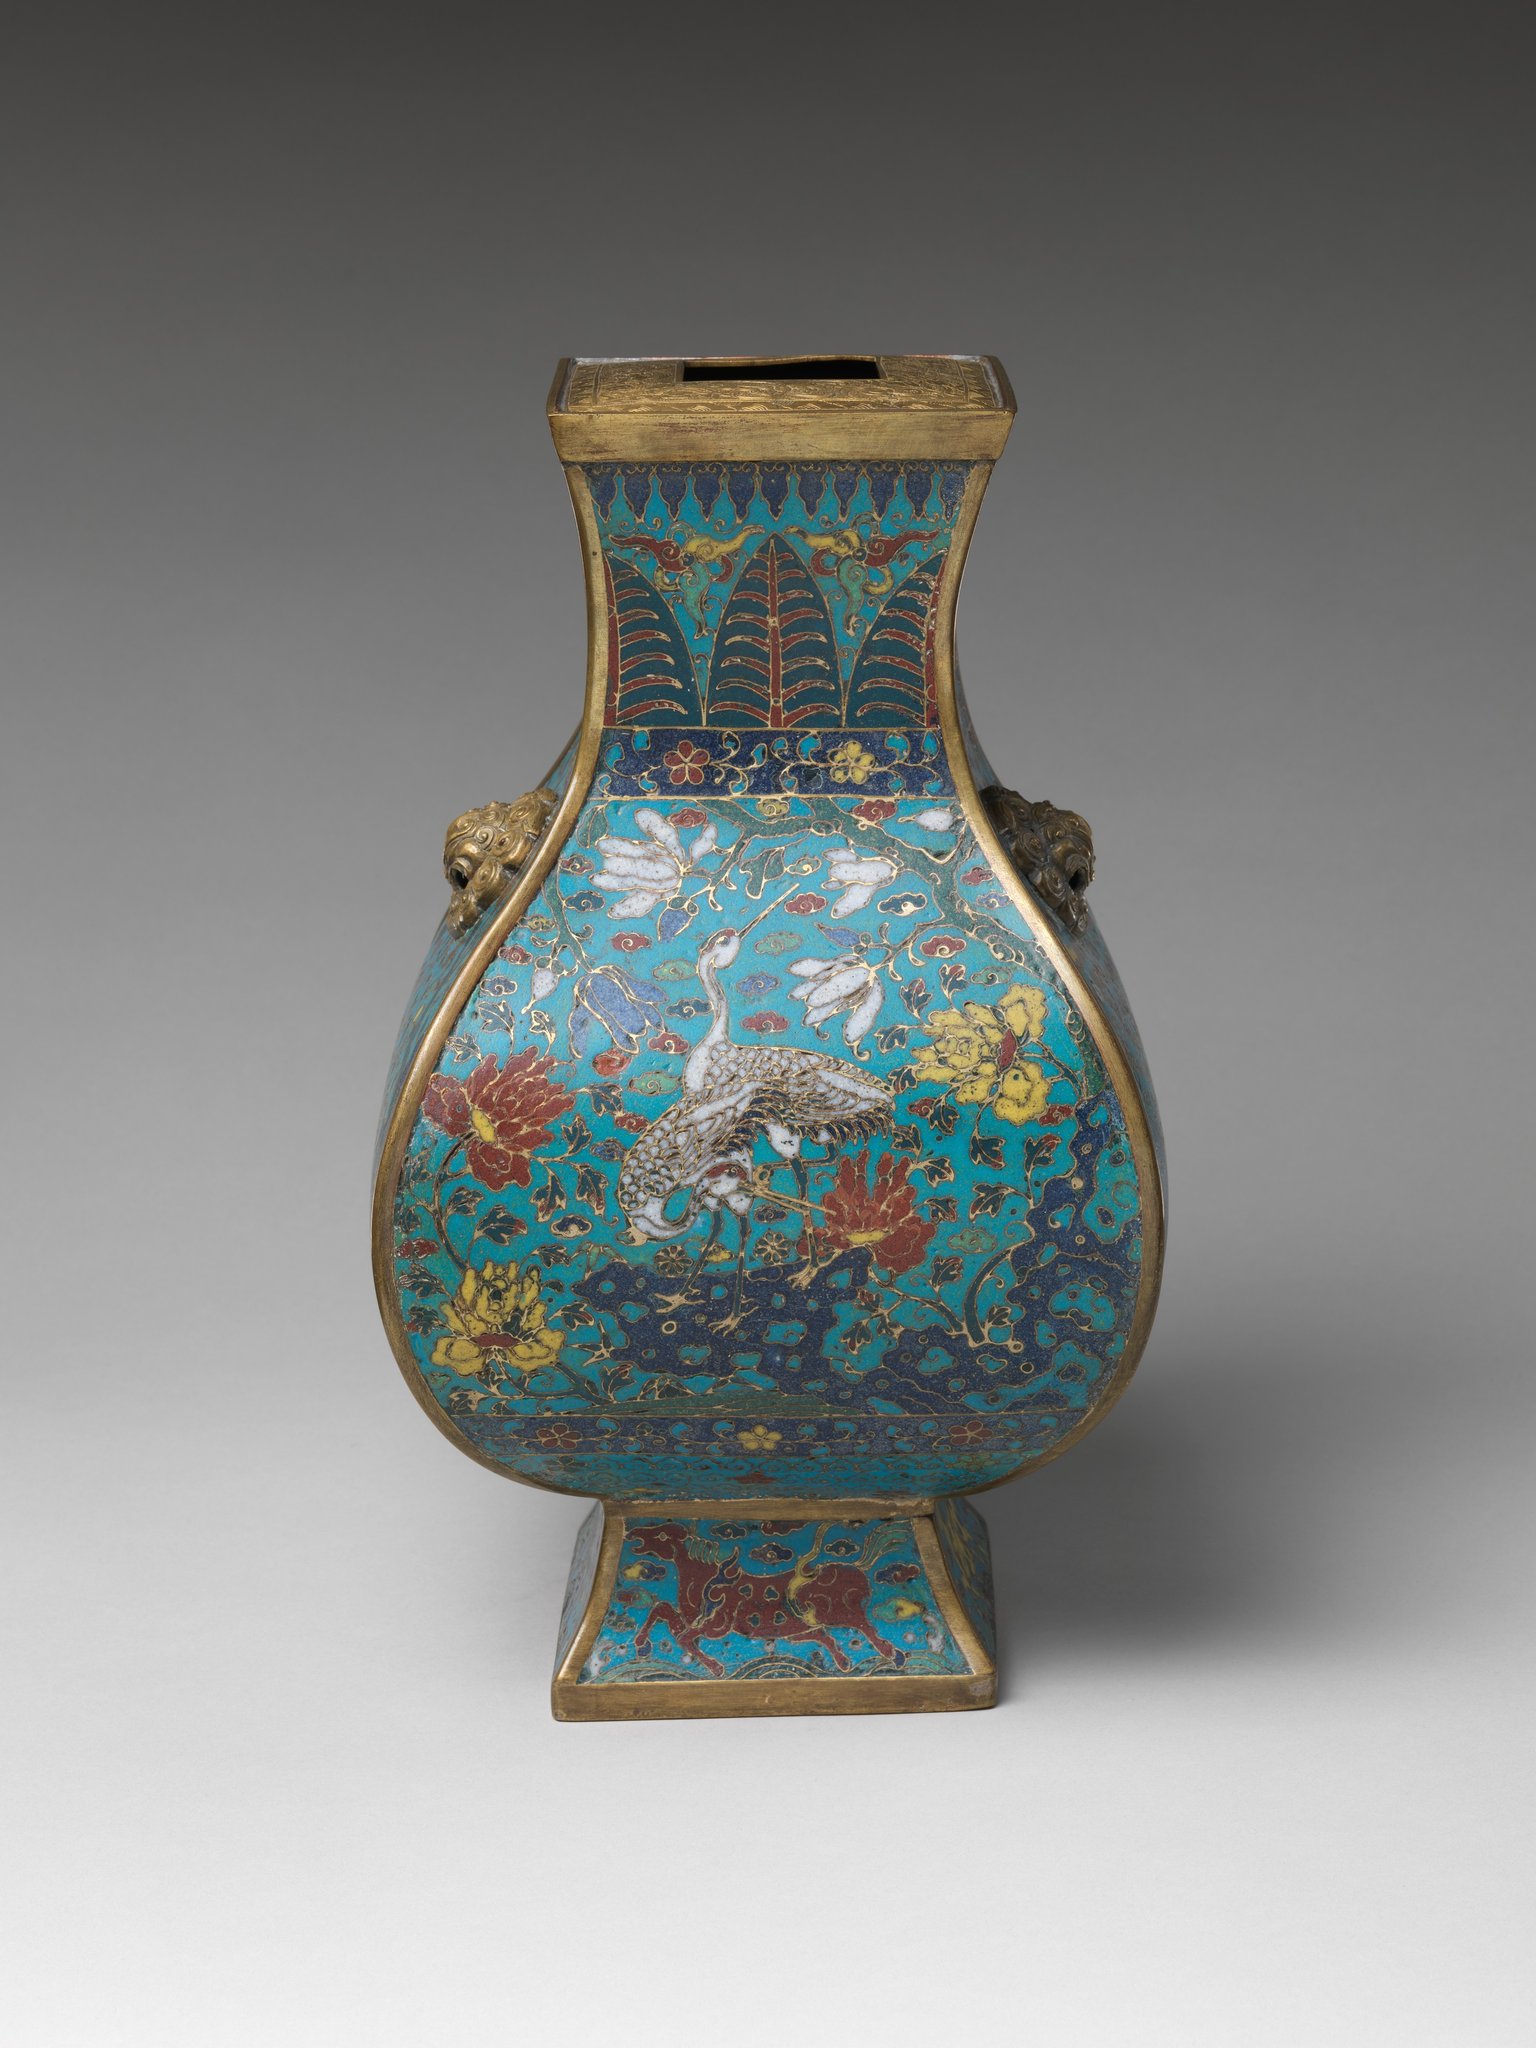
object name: vase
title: Vase with auspicious animals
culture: chinese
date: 1567-1700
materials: enamel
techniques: enamel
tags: animals,flowers